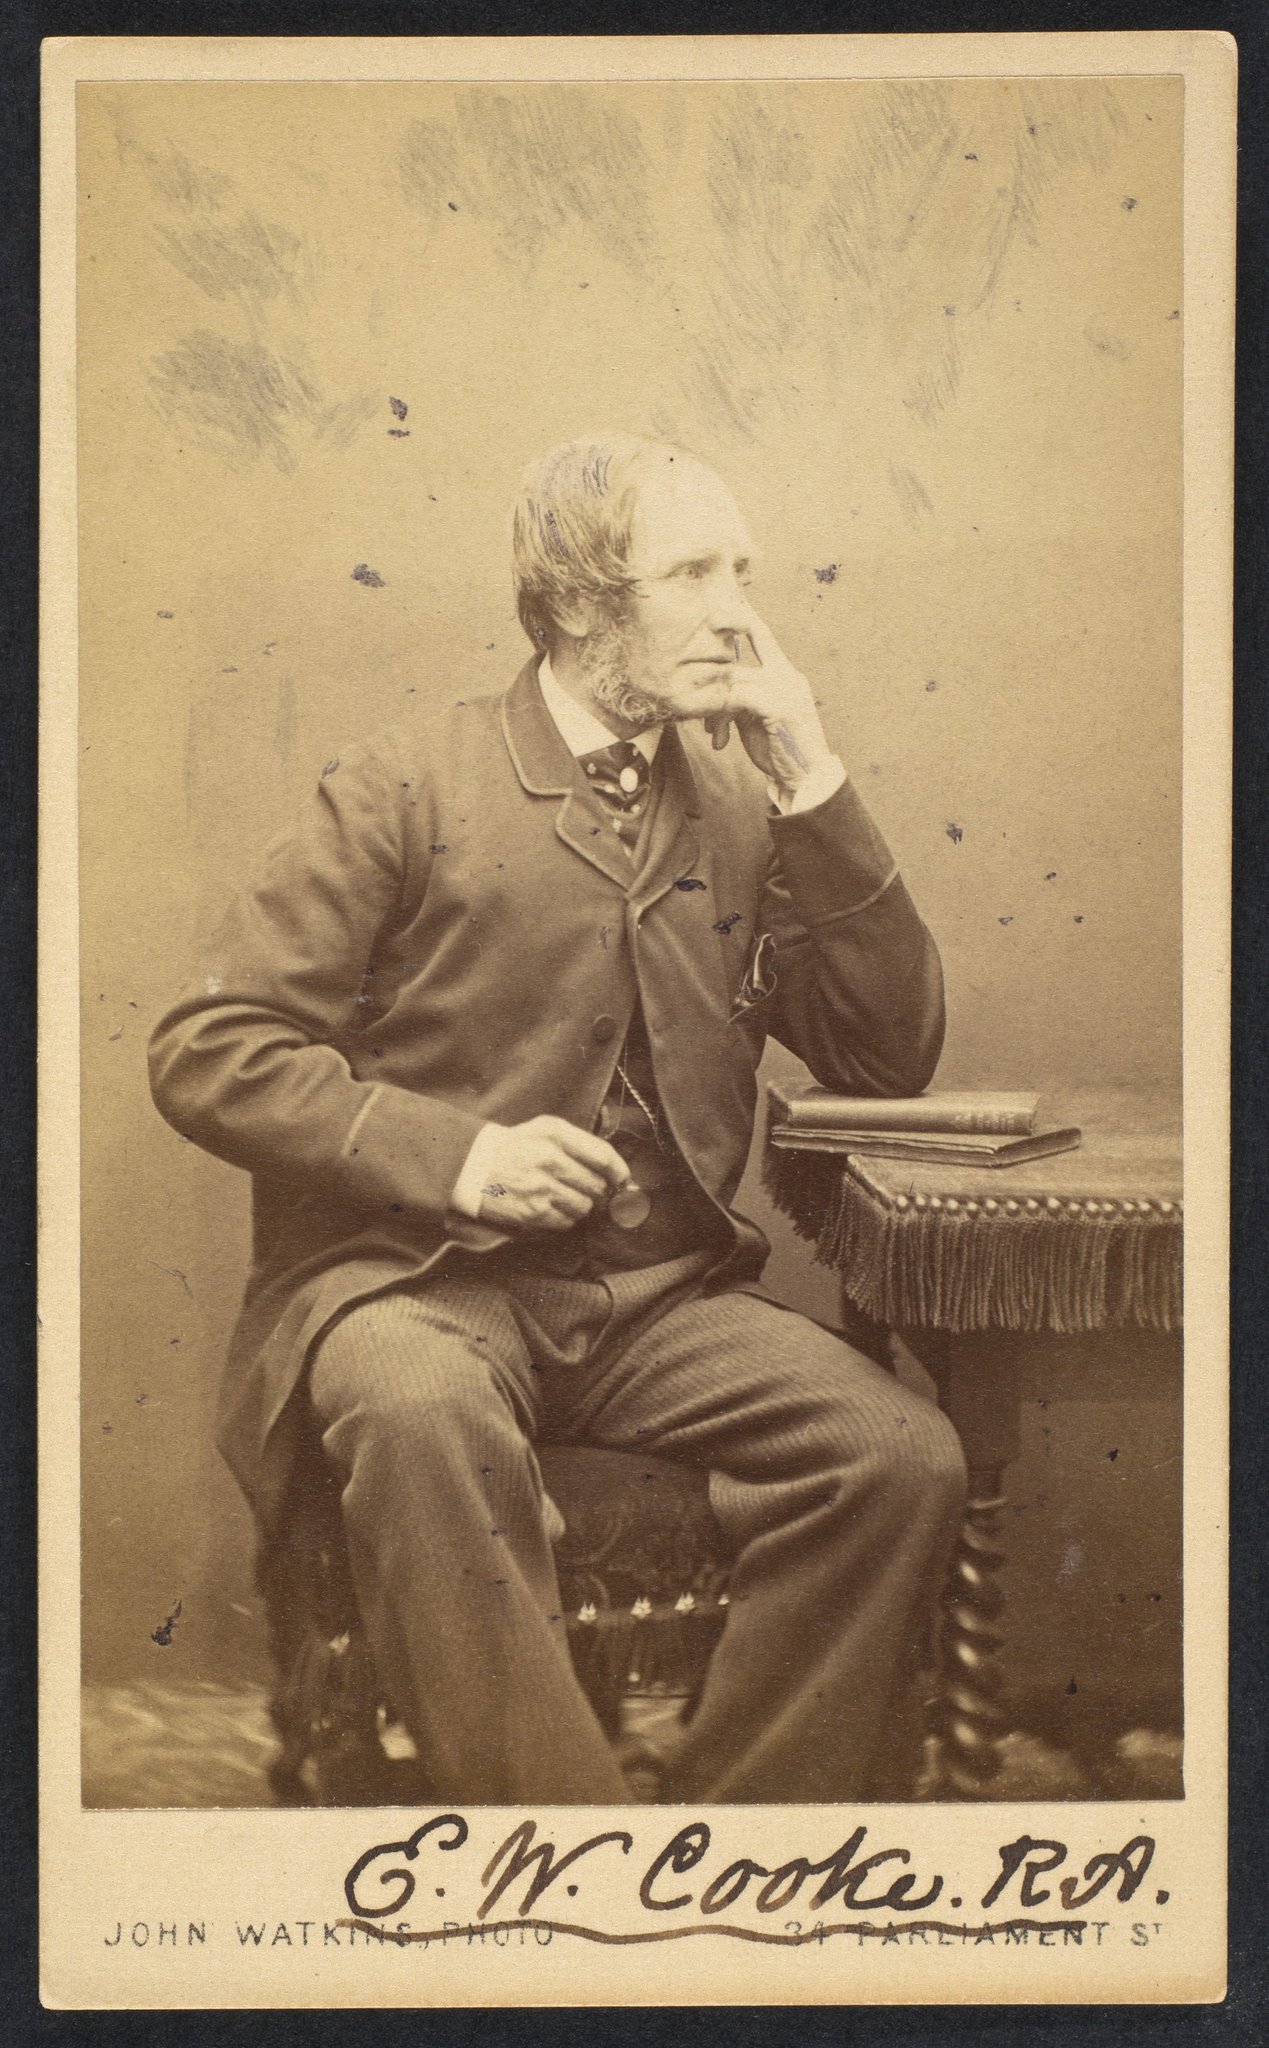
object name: carte de visite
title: [Edward William Cooke]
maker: john and charles watkins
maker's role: photography studio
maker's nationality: british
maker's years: 1840-1875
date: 1860-1869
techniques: albumen silver print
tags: men,portraits,profiles